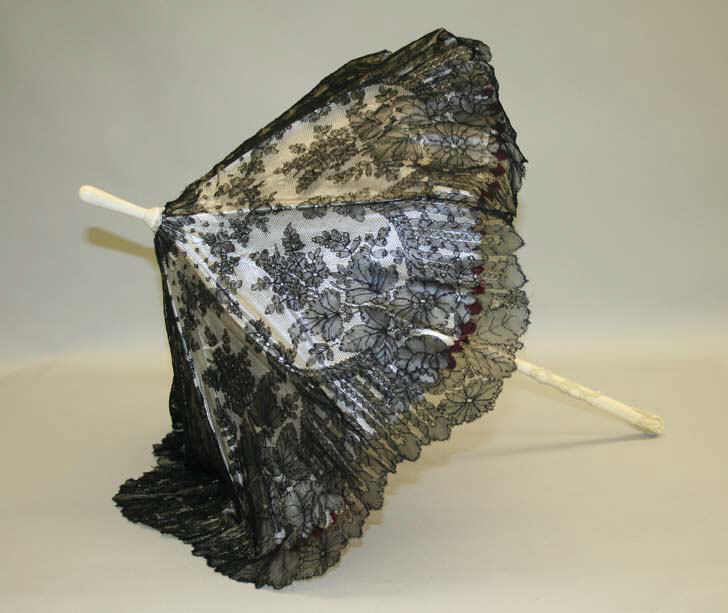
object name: promenade parasol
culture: american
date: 1860-1880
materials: ivory, metal, silk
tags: flowers